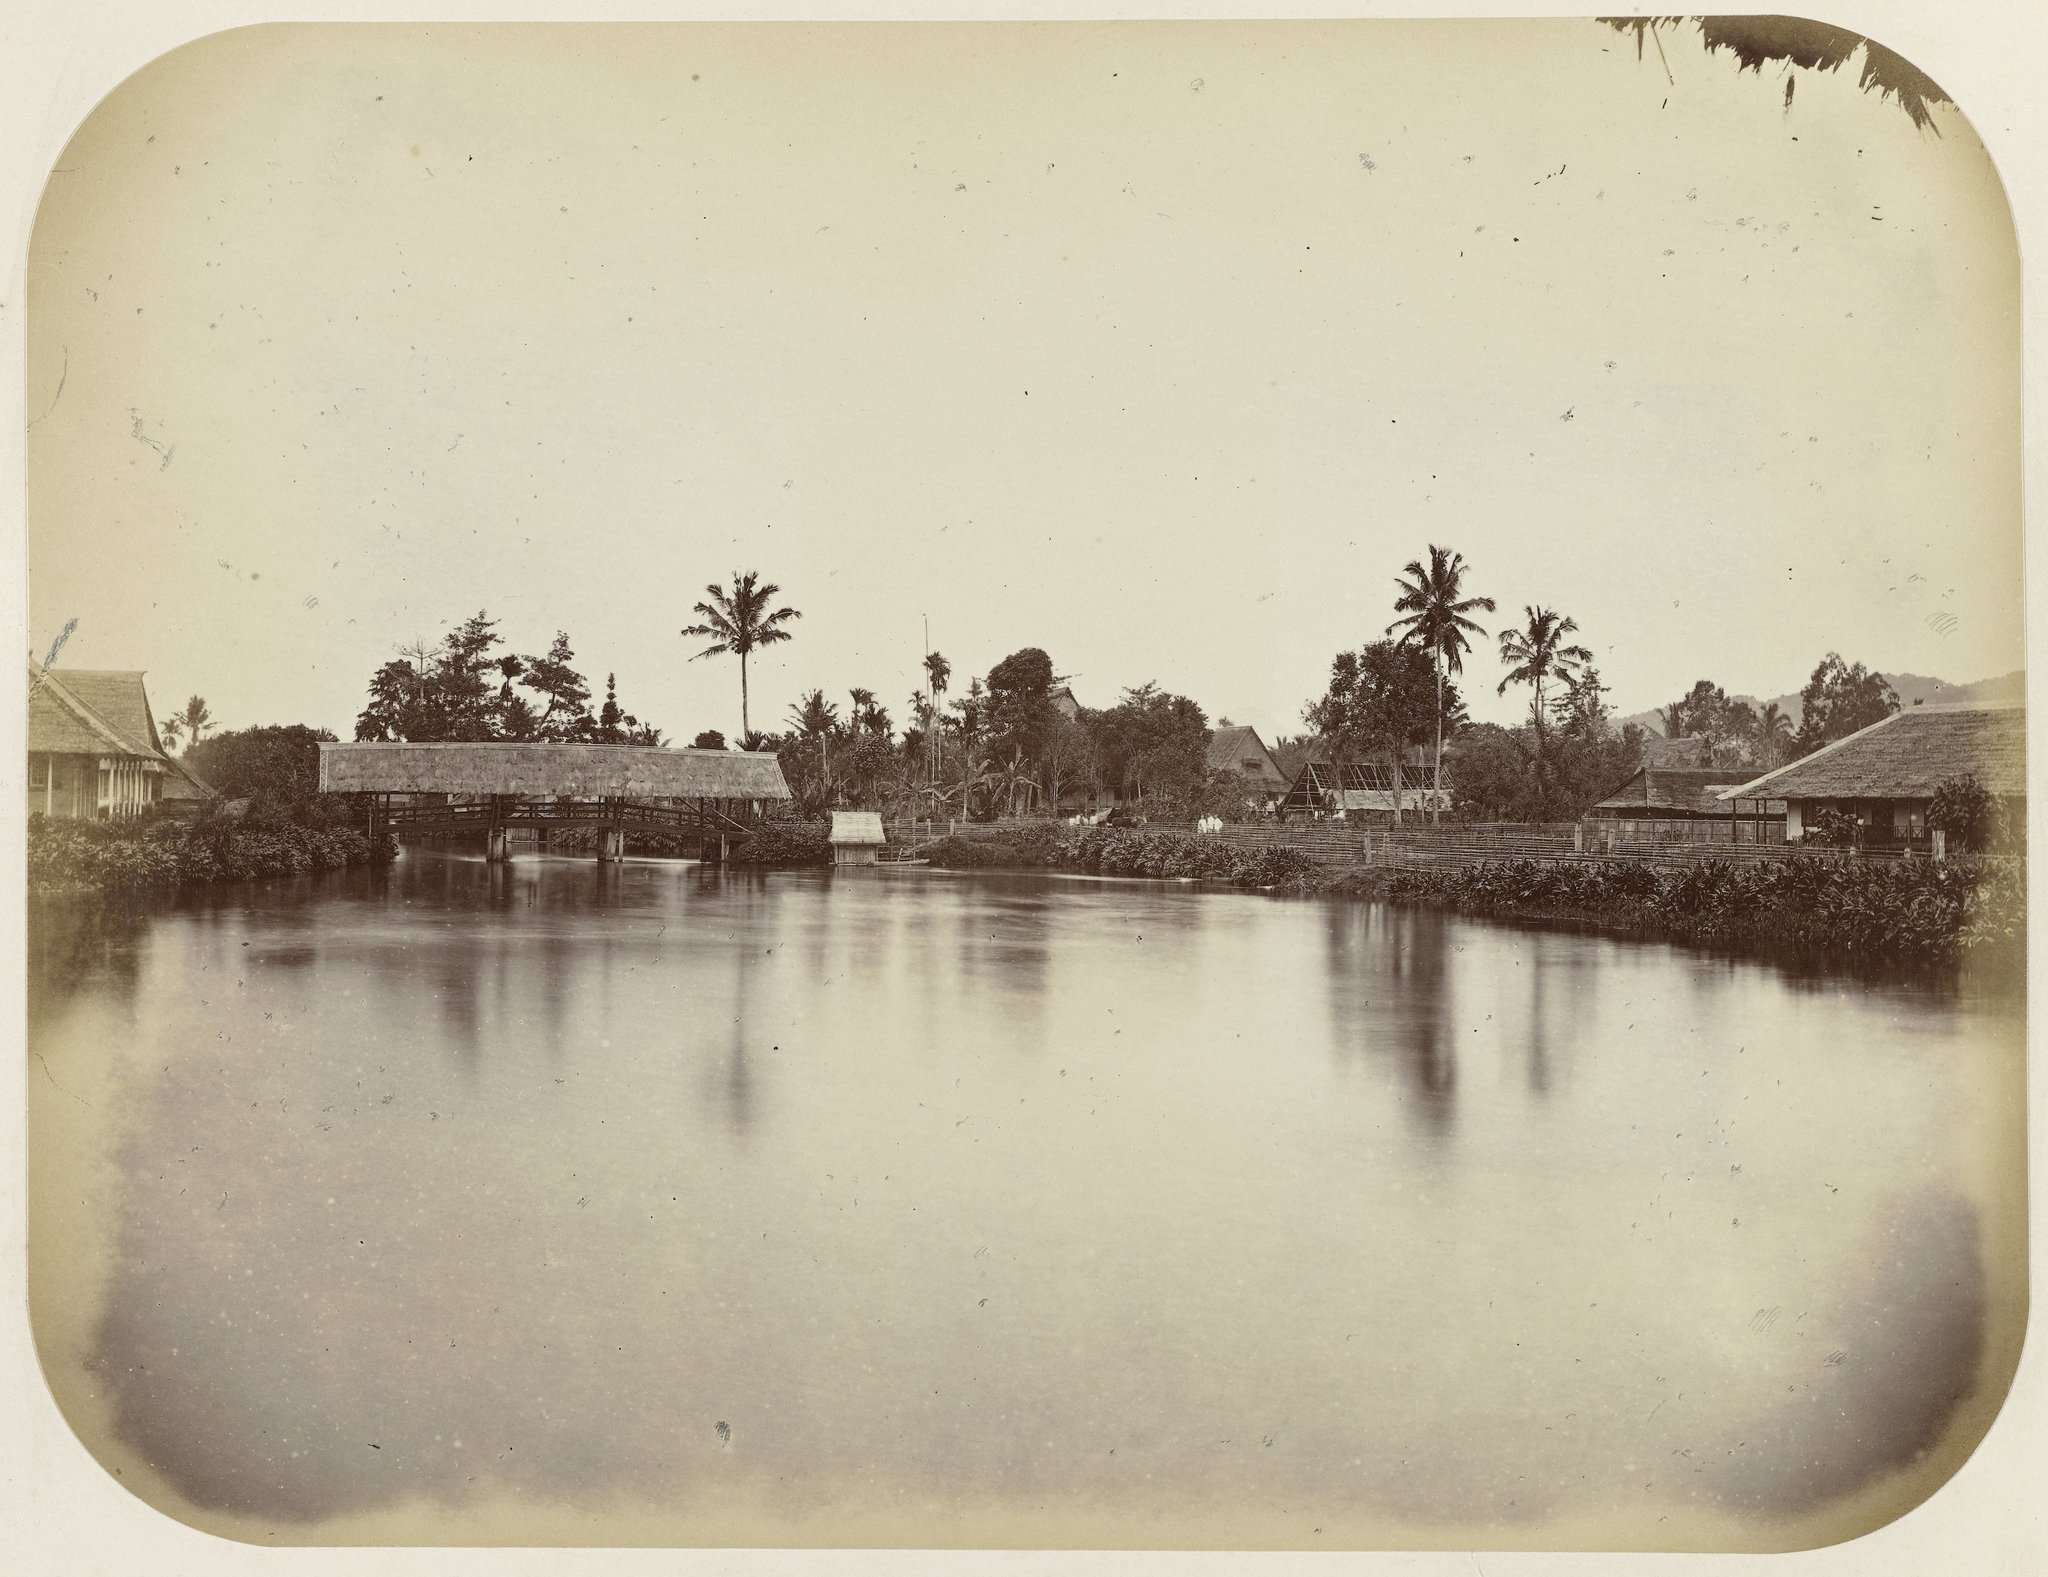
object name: photograph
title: Huizen aan de Tondano te Manado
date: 1860-1880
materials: photographic support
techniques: albumen print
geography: celebes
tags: villa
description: Huizen gelegen aan de rivier de Tondano te Manado op Celebes, in de verte een brug. Ingeplakte foto in het fotoalbum getiteld: Gezichten van Java.